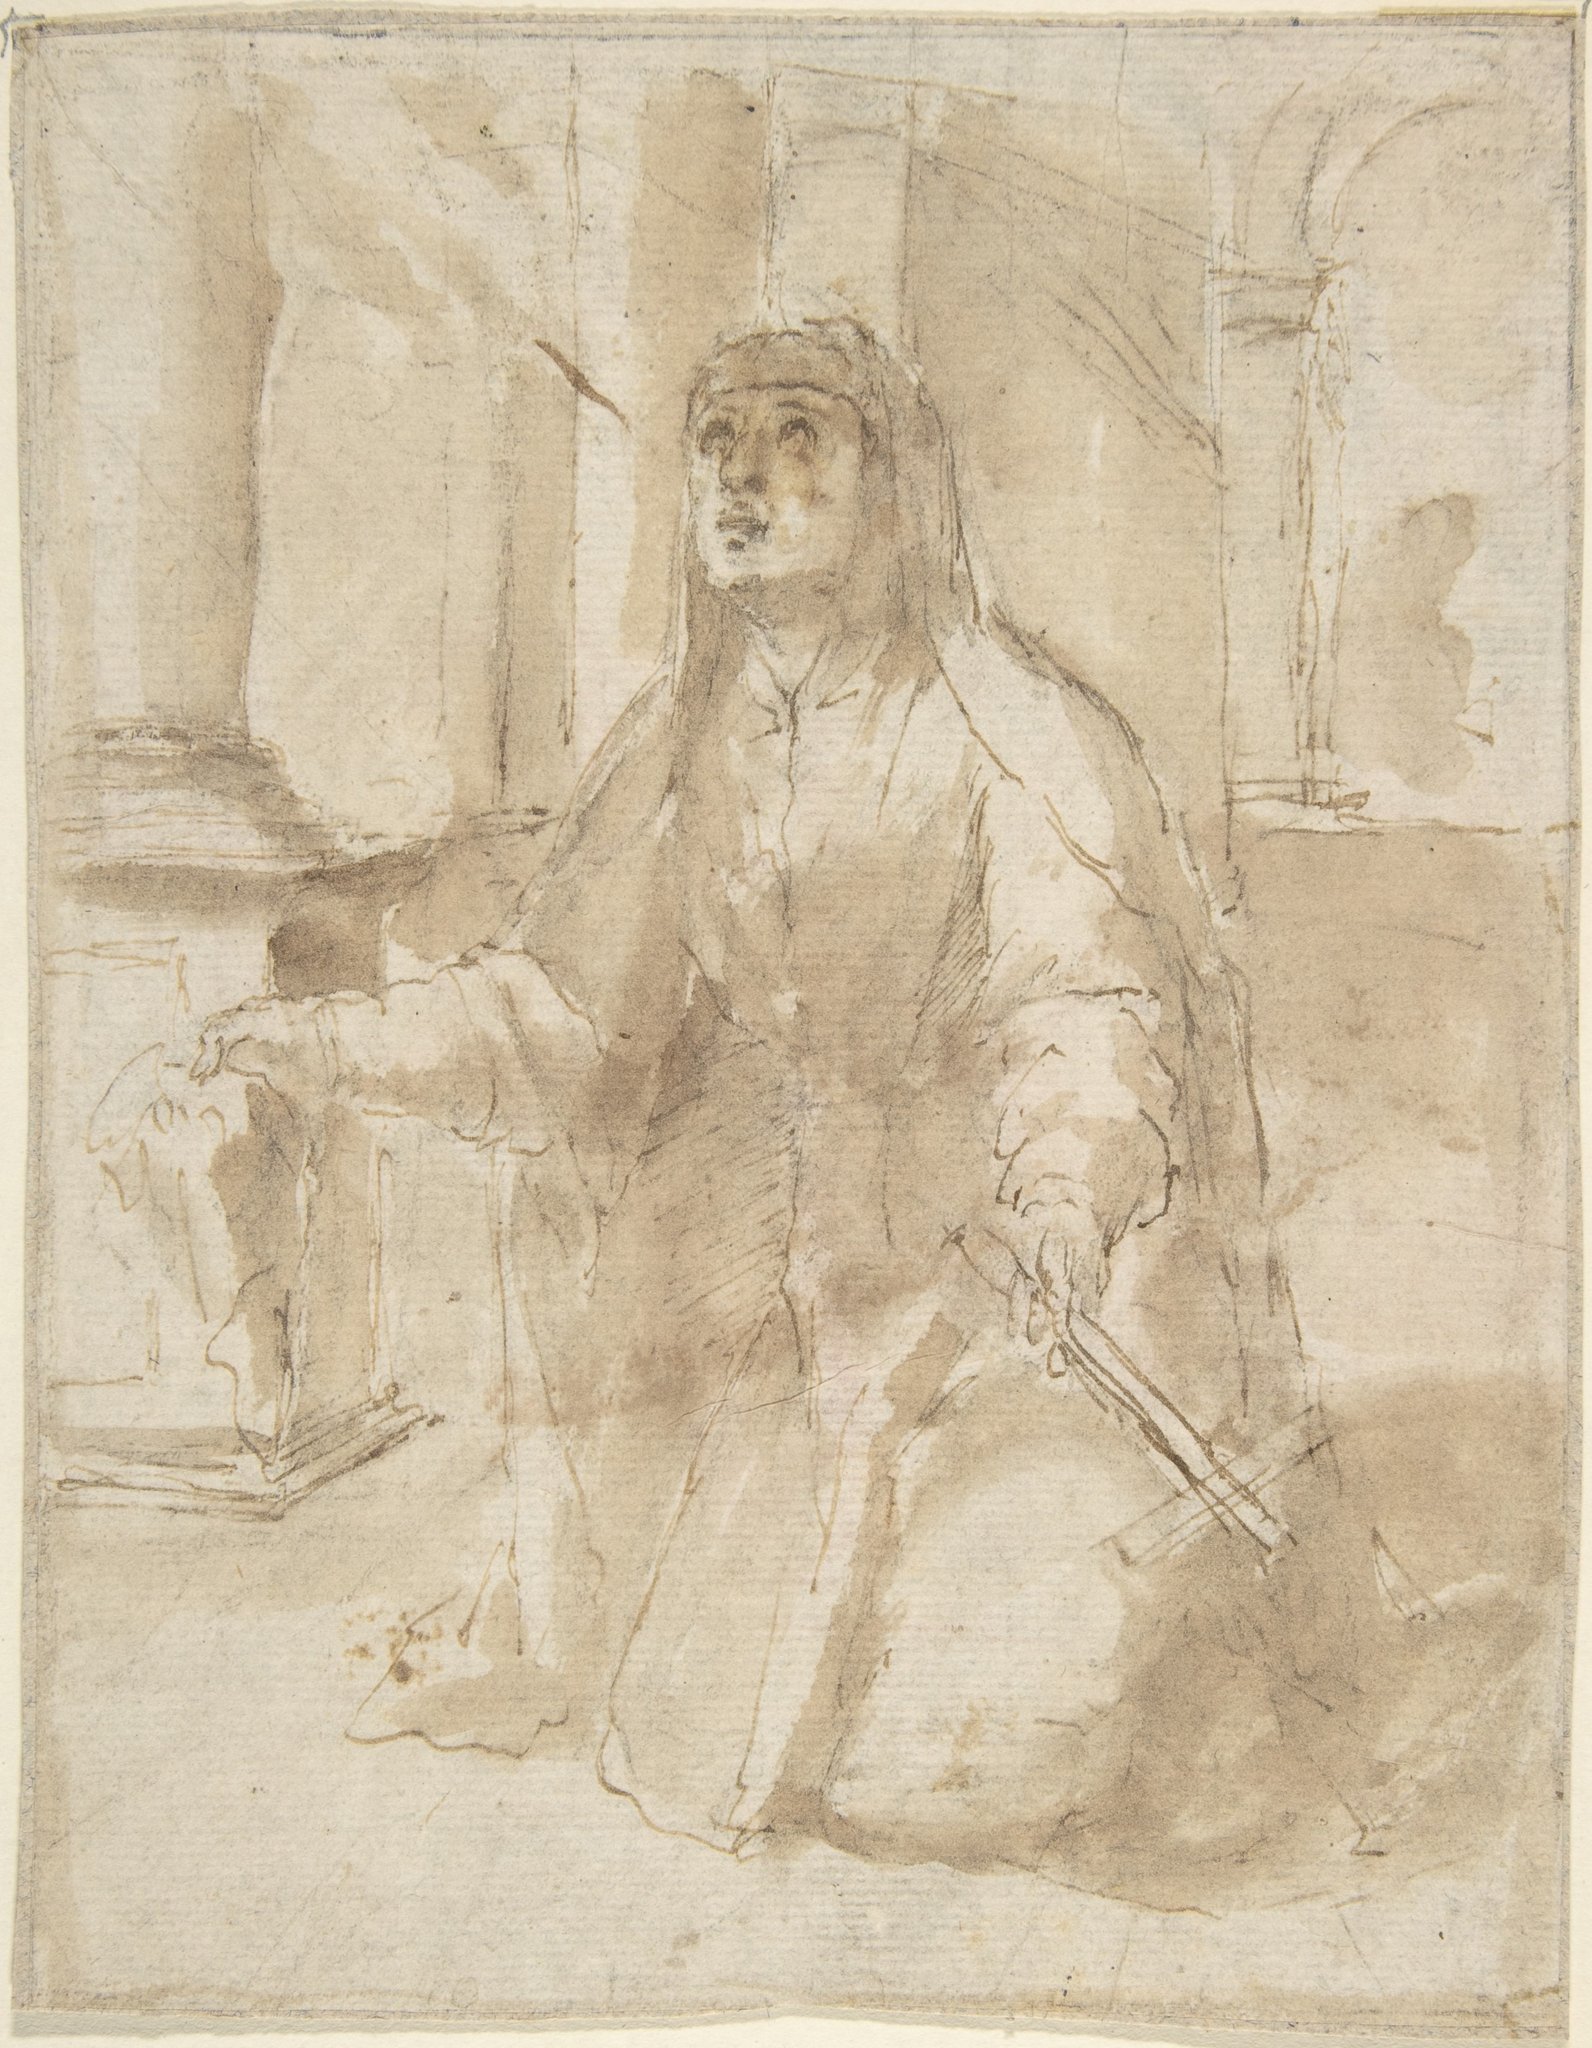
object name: drawing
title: Kneeling Figure of a Nun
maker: anonymous, spanish, school of seville, 17th century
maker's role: artist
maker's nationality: spanish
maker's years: 1600-1700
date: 1601-1700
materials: chalk, ink, paper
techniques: brush, pen, drawing, wash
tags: women,cross